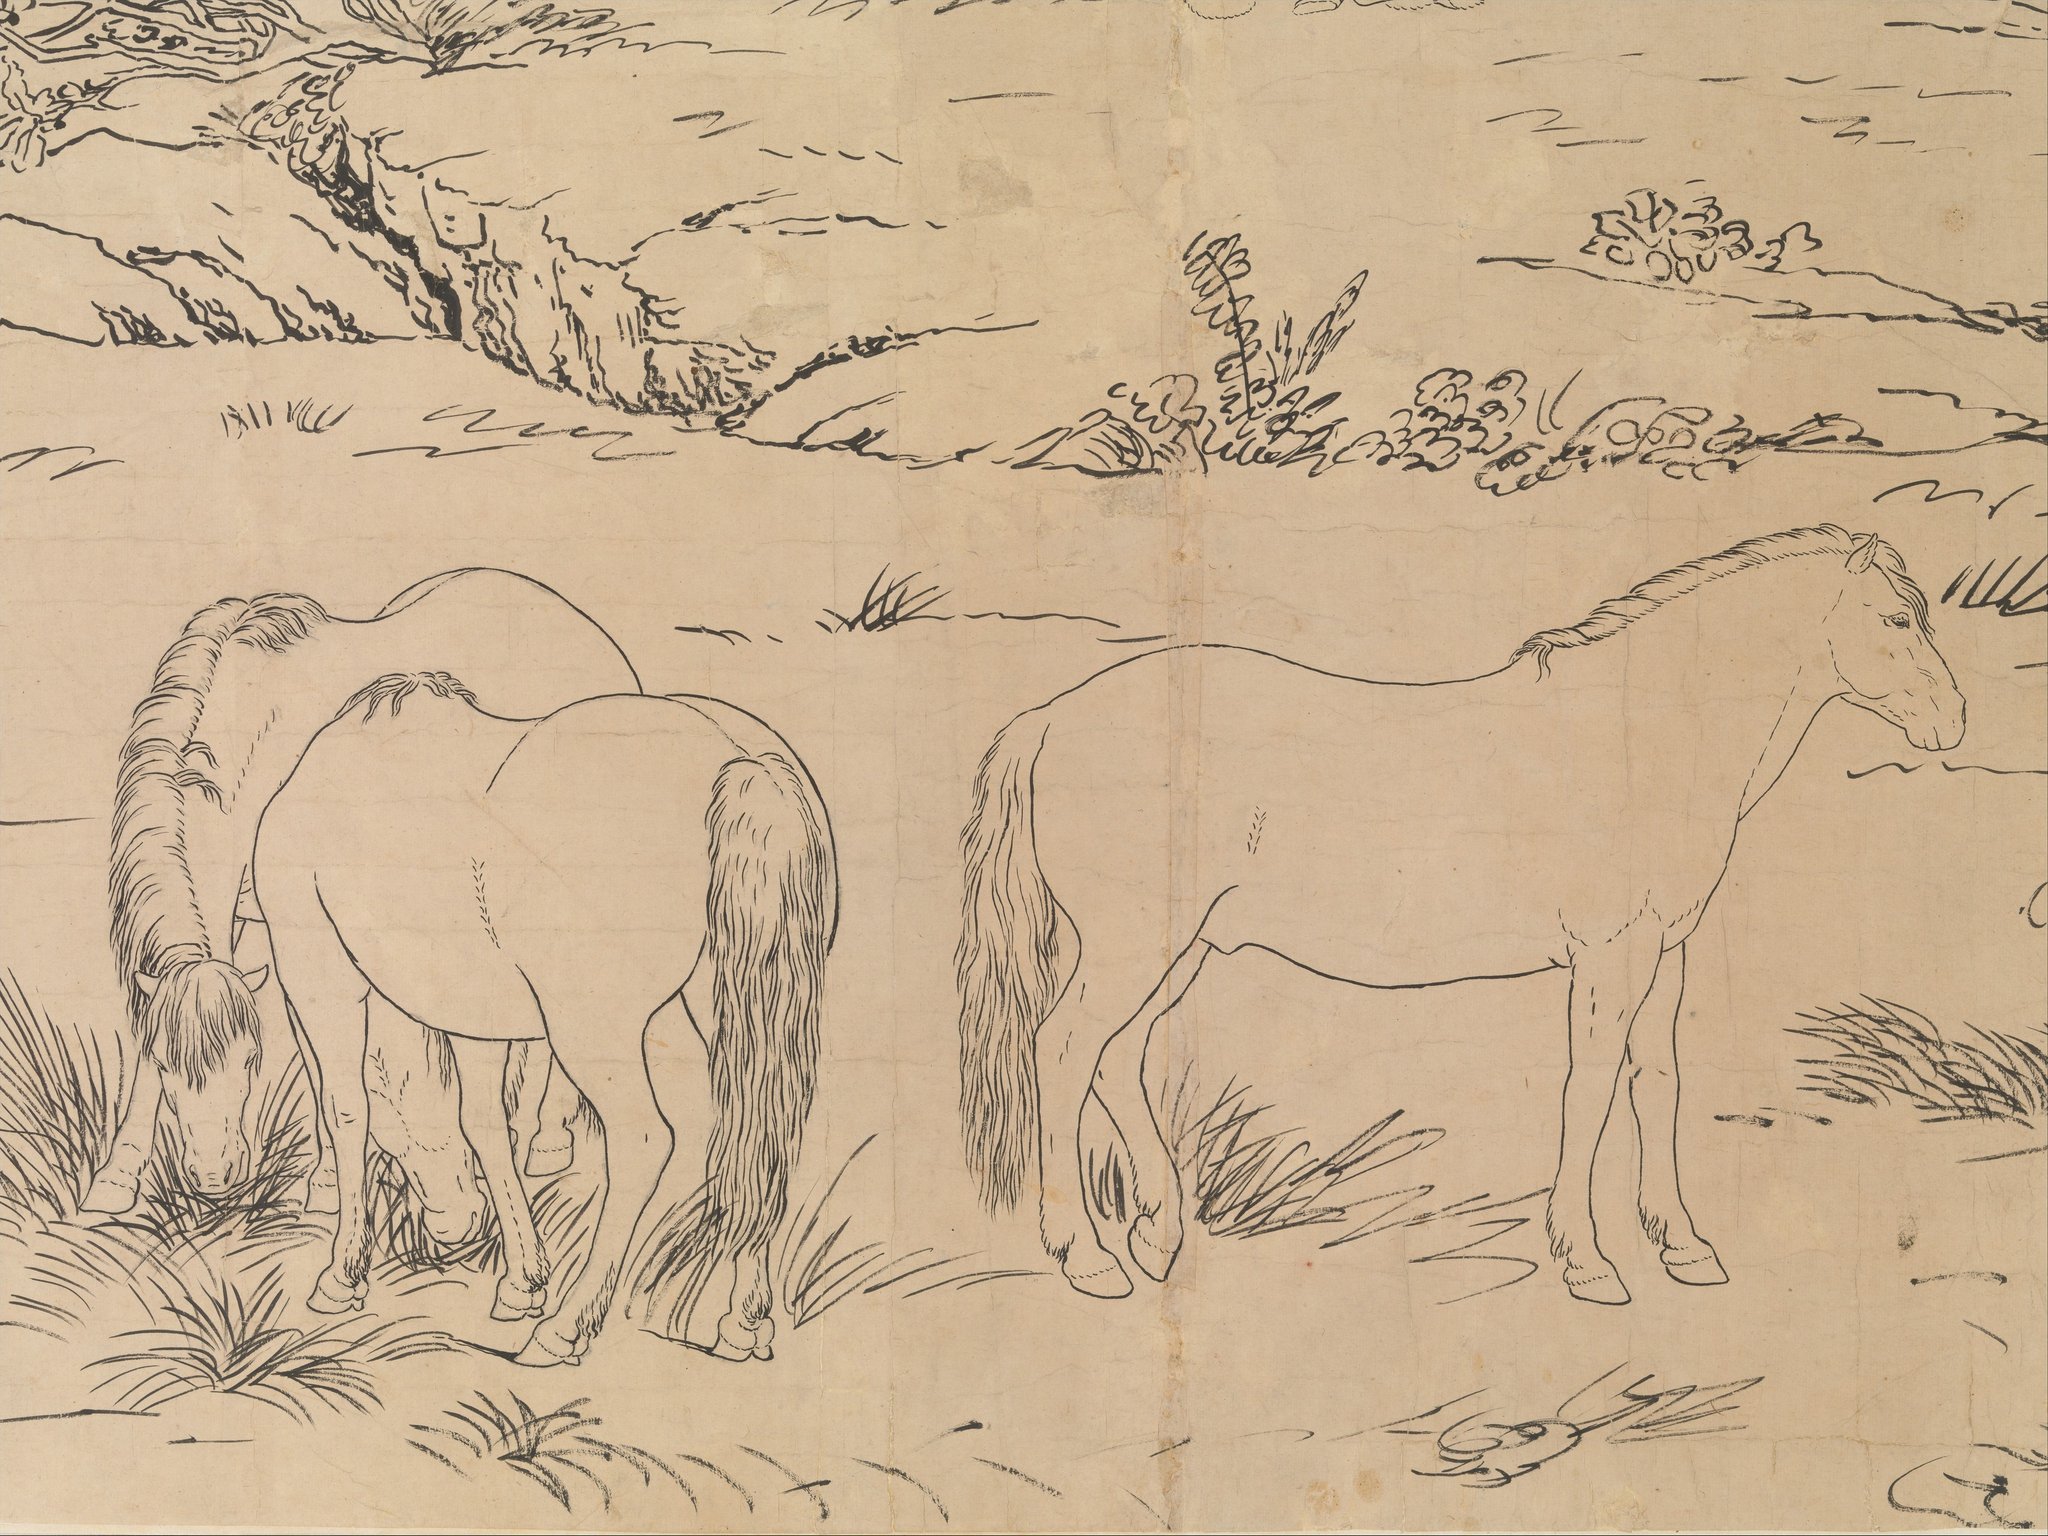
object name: handscroll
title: One Hundred Horses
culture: chinese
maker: giuseppe castiglione (lang shining 郎世寧)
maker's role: artist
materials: ink, paper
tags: horses